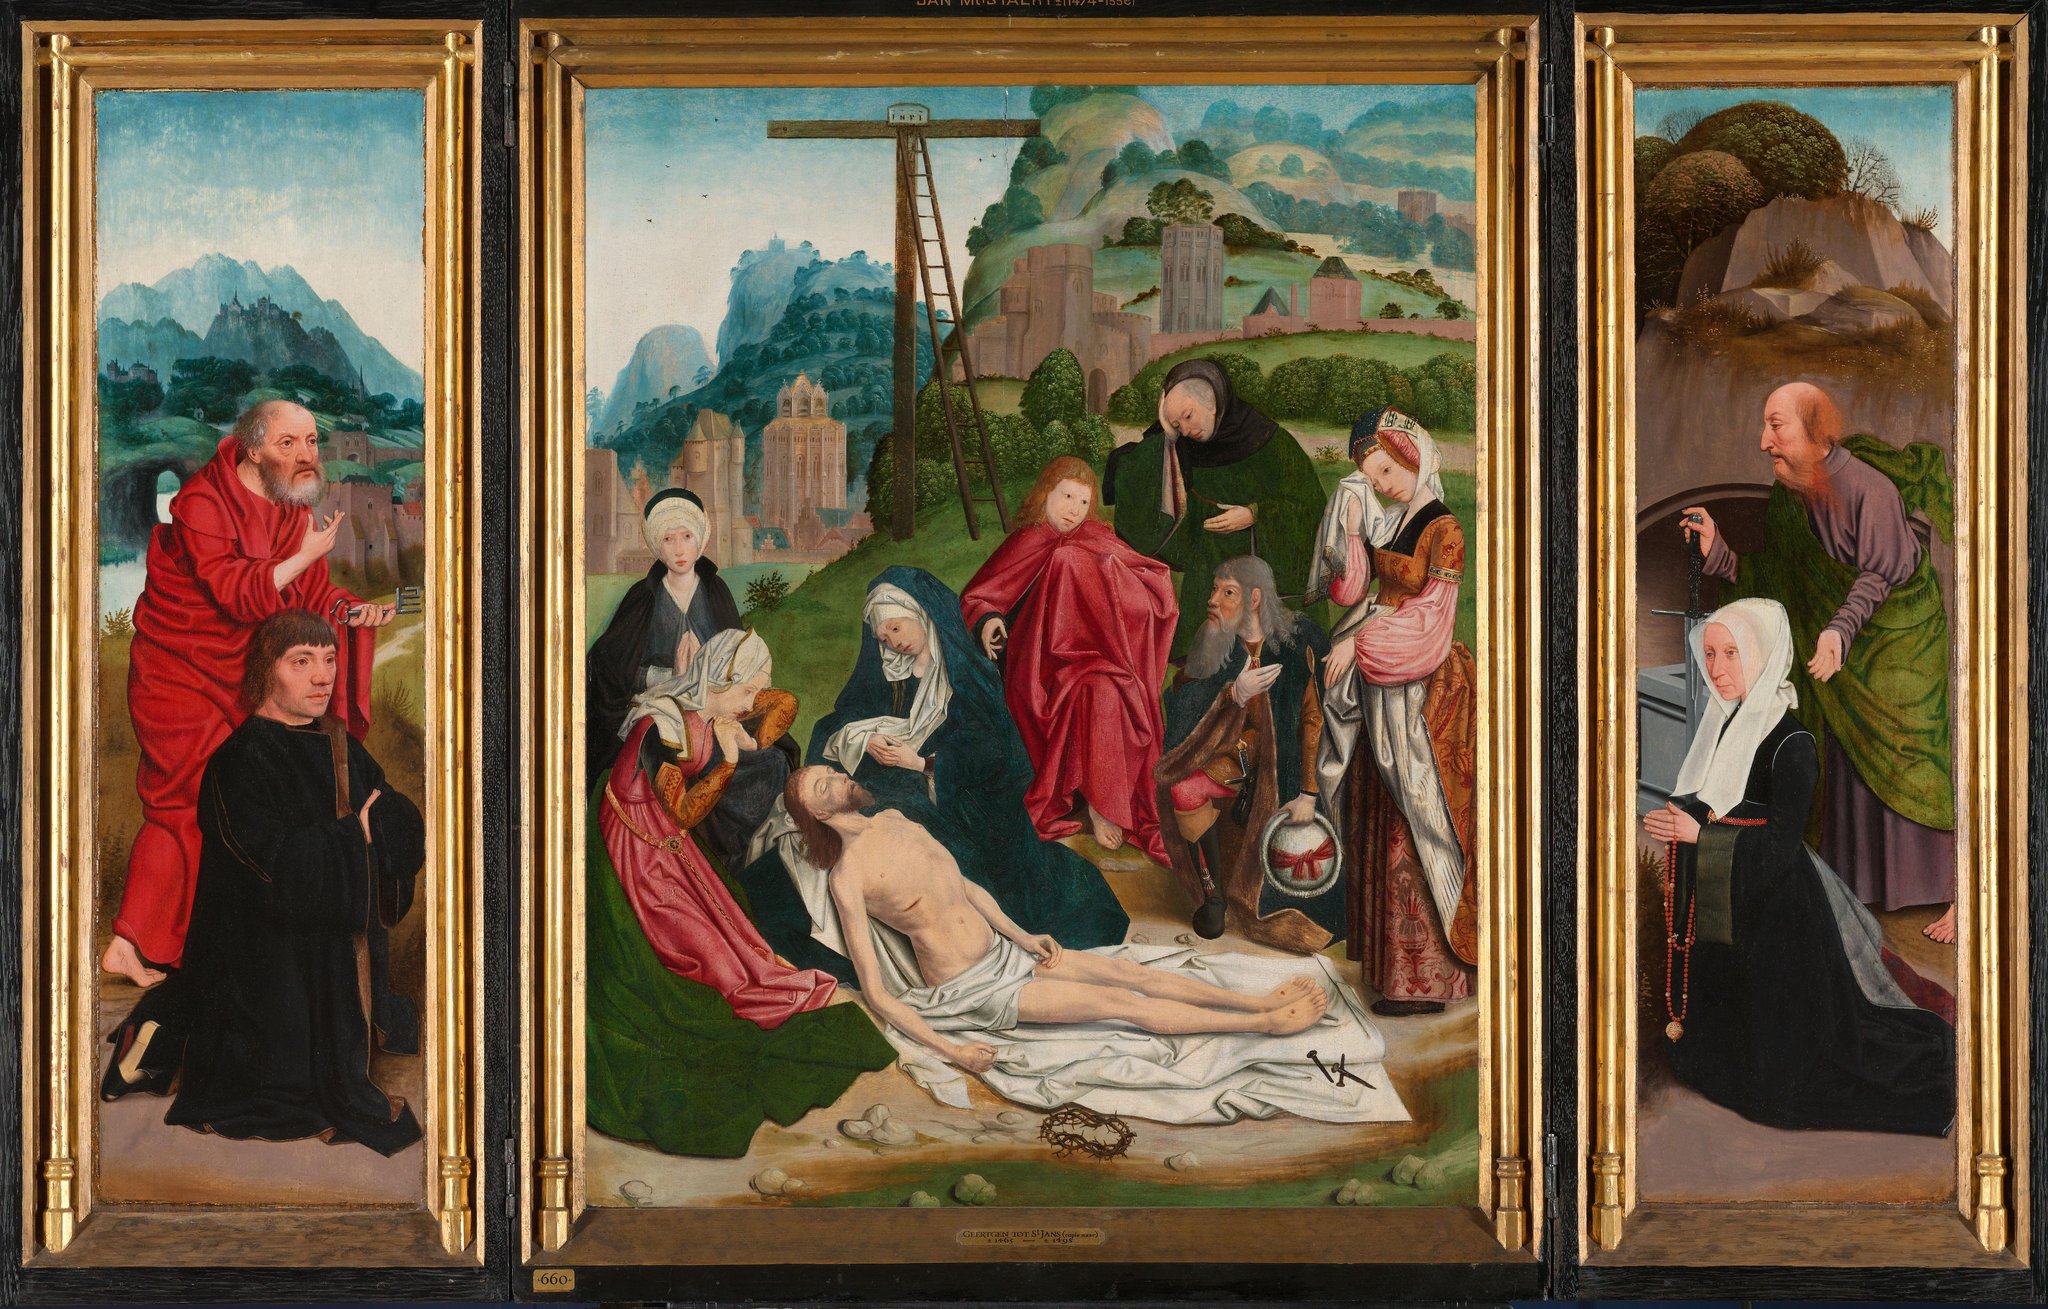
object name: painting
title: Triptych with the Lamentation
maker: jan jansz mostaert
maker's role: draughtsman, painter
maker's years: 1465-1553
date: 1515-1520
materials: oil, panel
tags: christ's body lying on the ground (+ donor(s), supplicant(s), whether or not with patron saint(s))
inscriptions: coat of arms, outer left wing: a gold star with two gold lozenges above and one gold lozenge below, on a red field, coat of arms, outer right wing: a red squirrel with two black hunting horns above and one black hunting horn below, on a gold field, date, on the outer wings: ‘Anno 15(7?)7’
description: Drieluik met de bewening. Op het middenpaneel de bewening van Christus in een landschap. Het lichaam van Christus ligt tegen de knie van Maria. Om haar heen de heilige vrouwen, Johannes, Jozef en een monnik. De bewening is een vrije kopie naar het schilderij van Geertgen tot Sint Jans in Wenen. Op de binnenzijde van het linker zijpaneel een knielende stichter met de heilige Petrus. Op de binnenzijde van het rechter zijpaneel de knielende stichteres met de heilige Paulus. Op de buitenzijde van de zijpanelen de wapens van stichter (de familie Speyart van Woerden) en zijn vrouw.